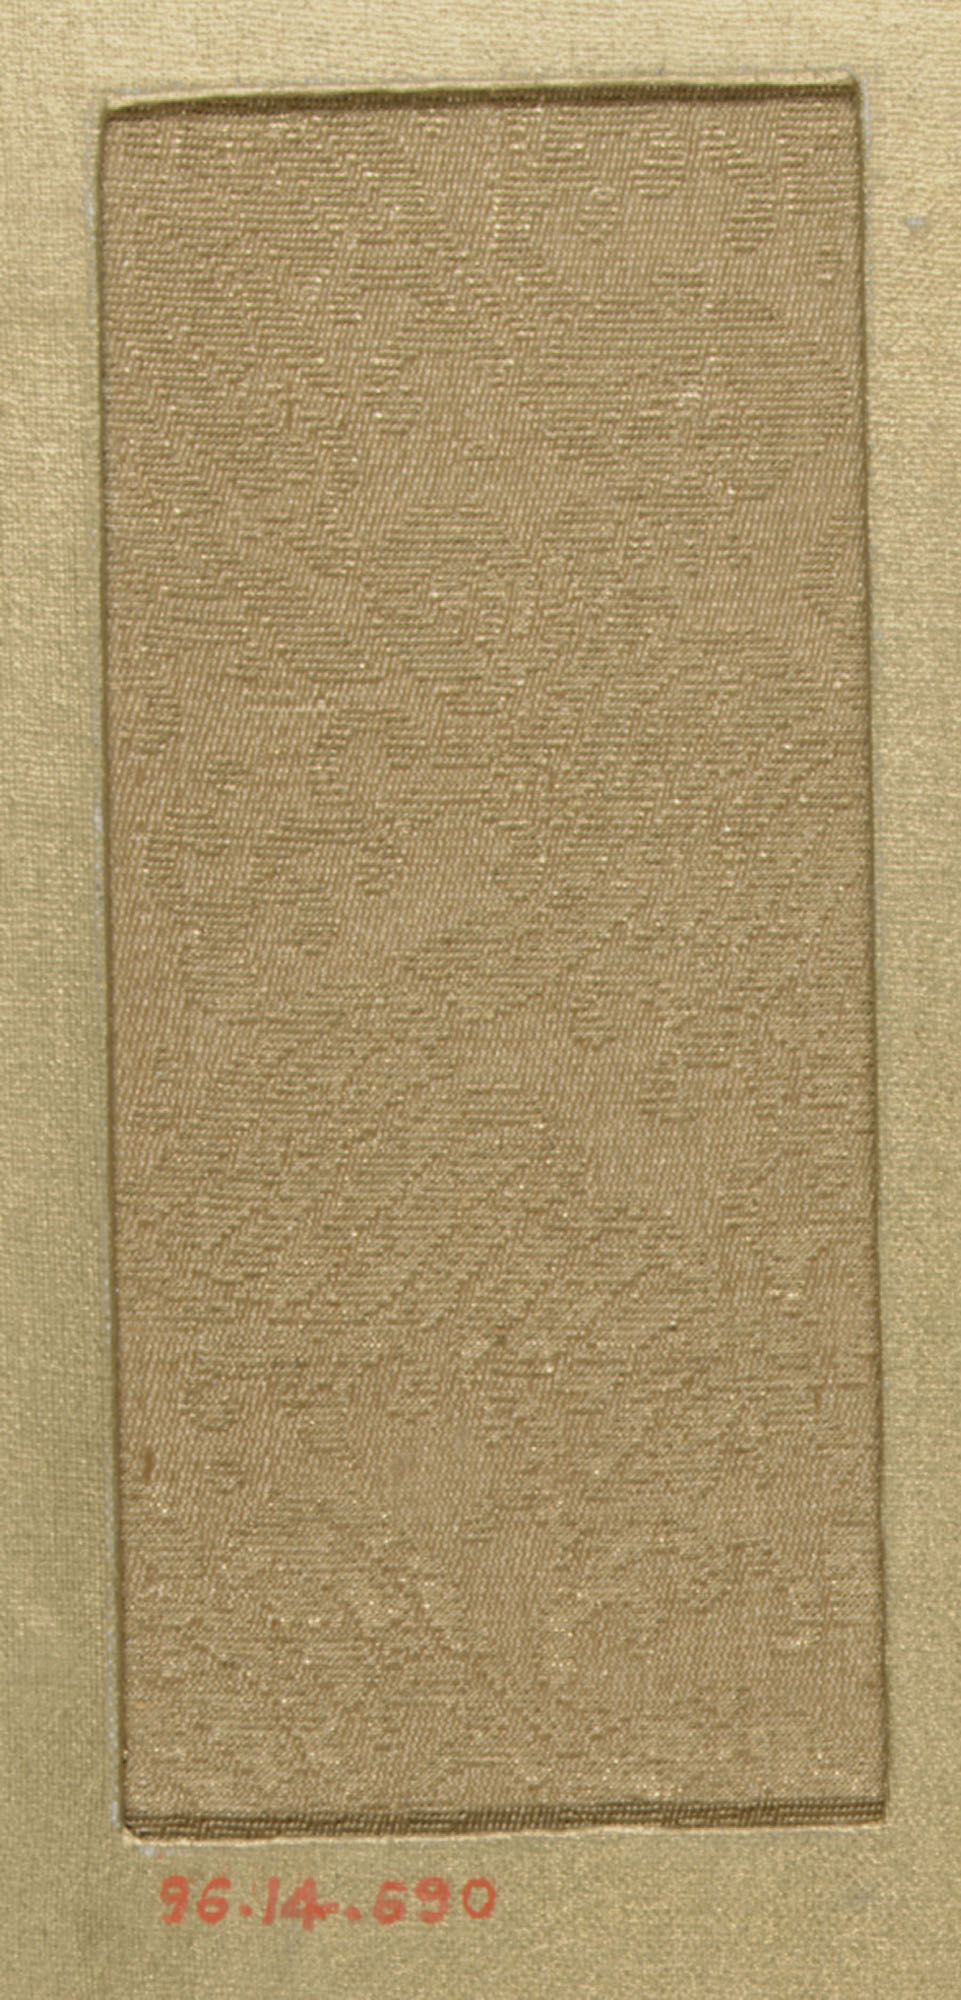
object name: piece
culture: japanese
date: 1701-1900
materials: silk